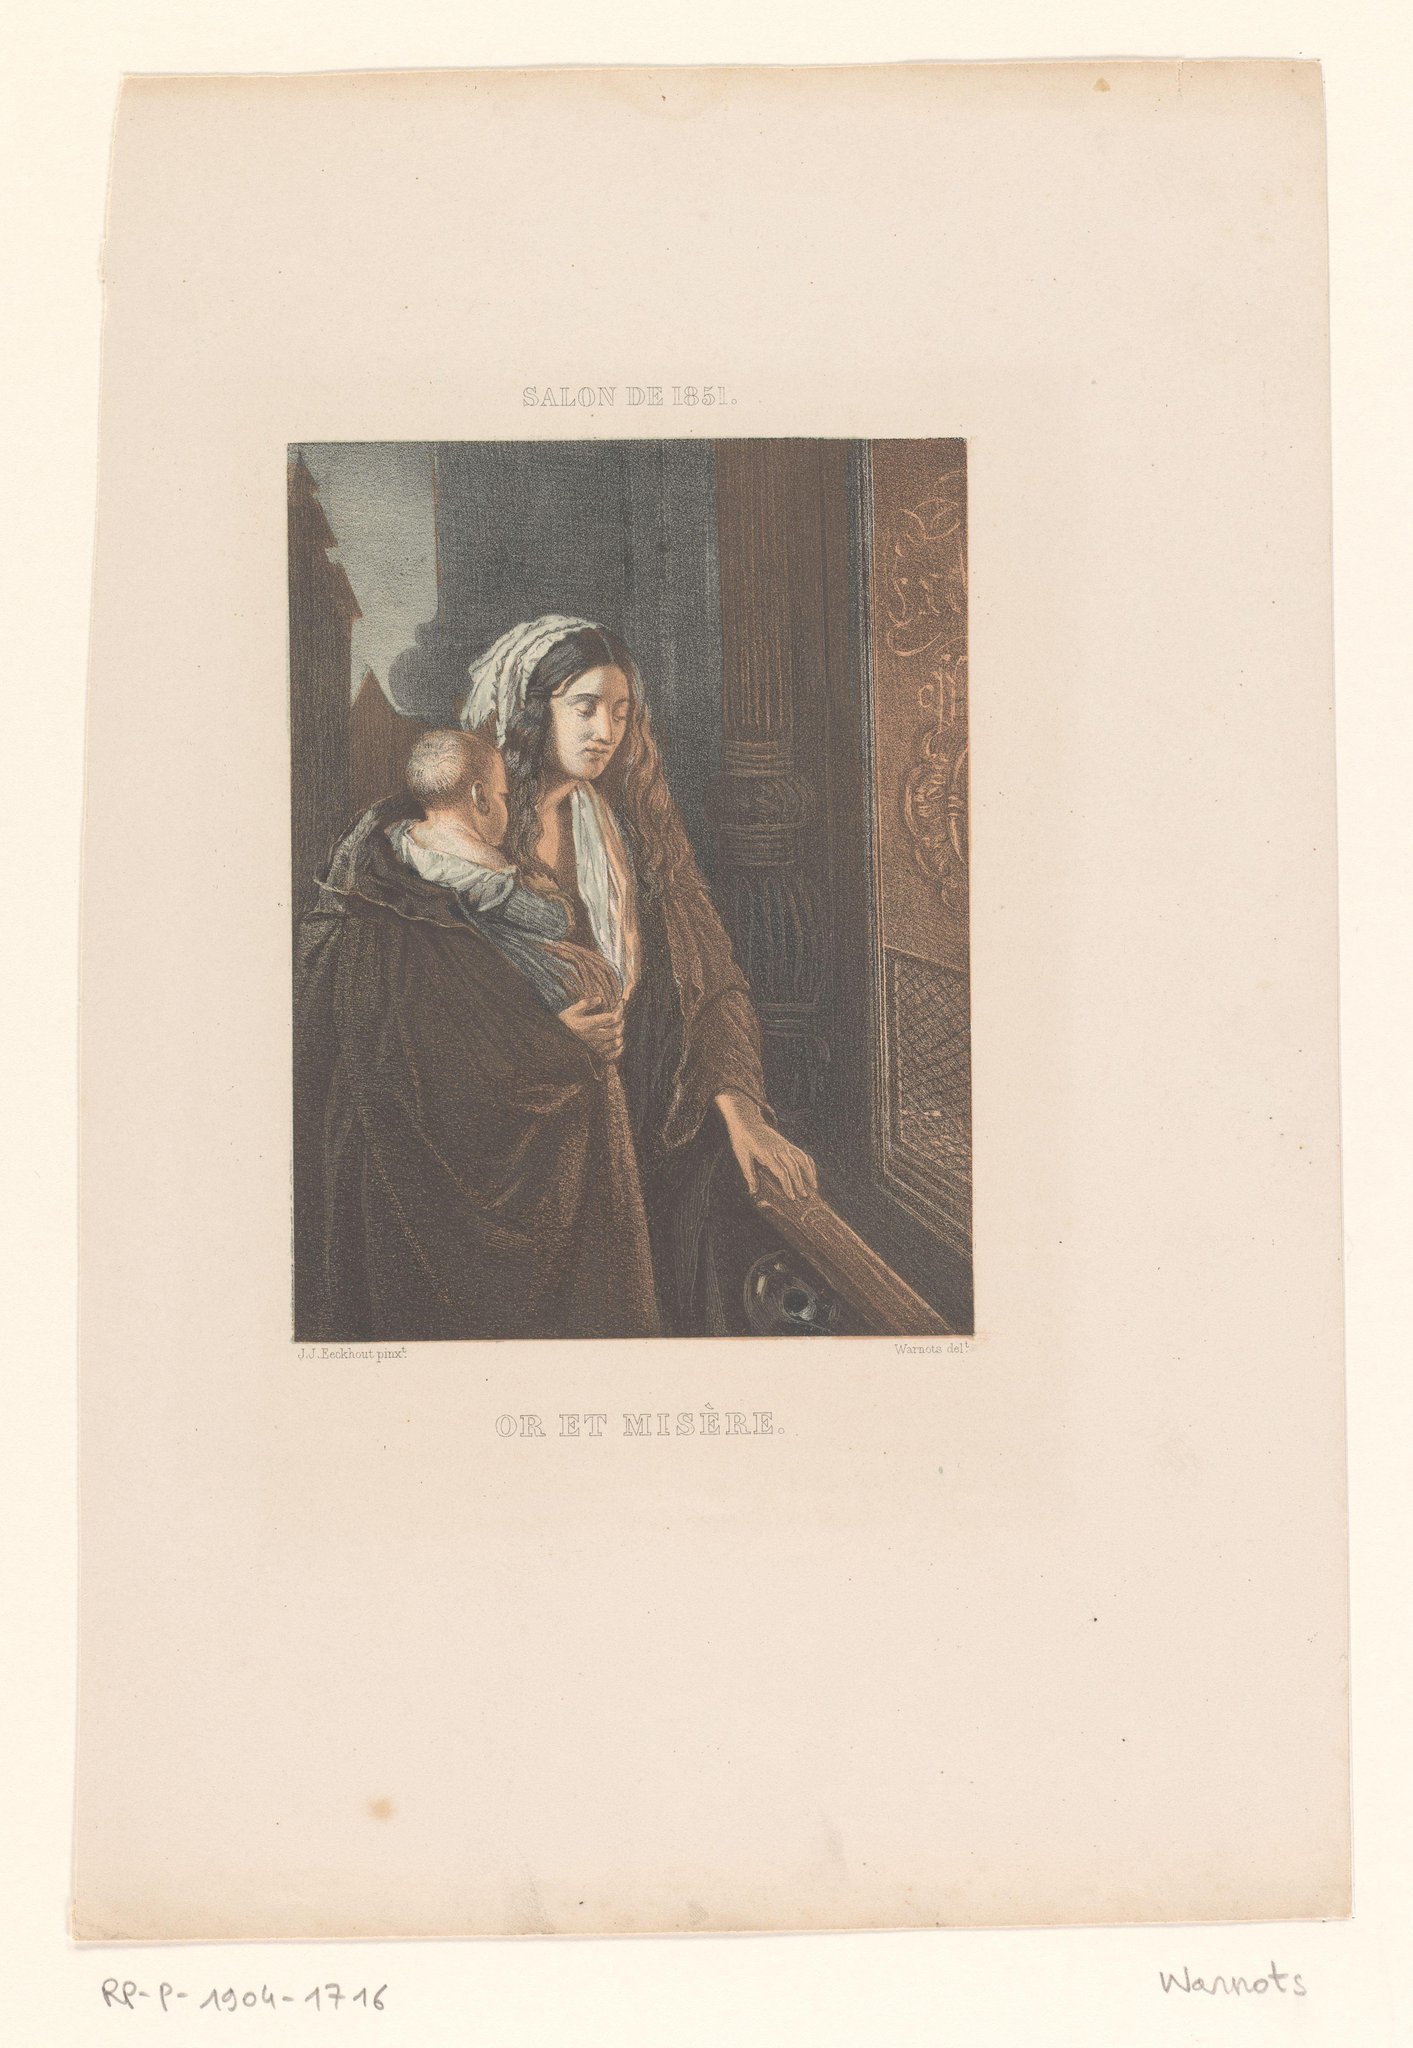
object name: print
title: Or et misère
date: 1851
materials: paper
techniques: lithograph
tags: mother and baby or young child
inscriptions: collector's mark: Lugt 2228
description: Prent uit: La Renaissance. Chronique des arts et de la littérature 13 (1851), pl. 14.